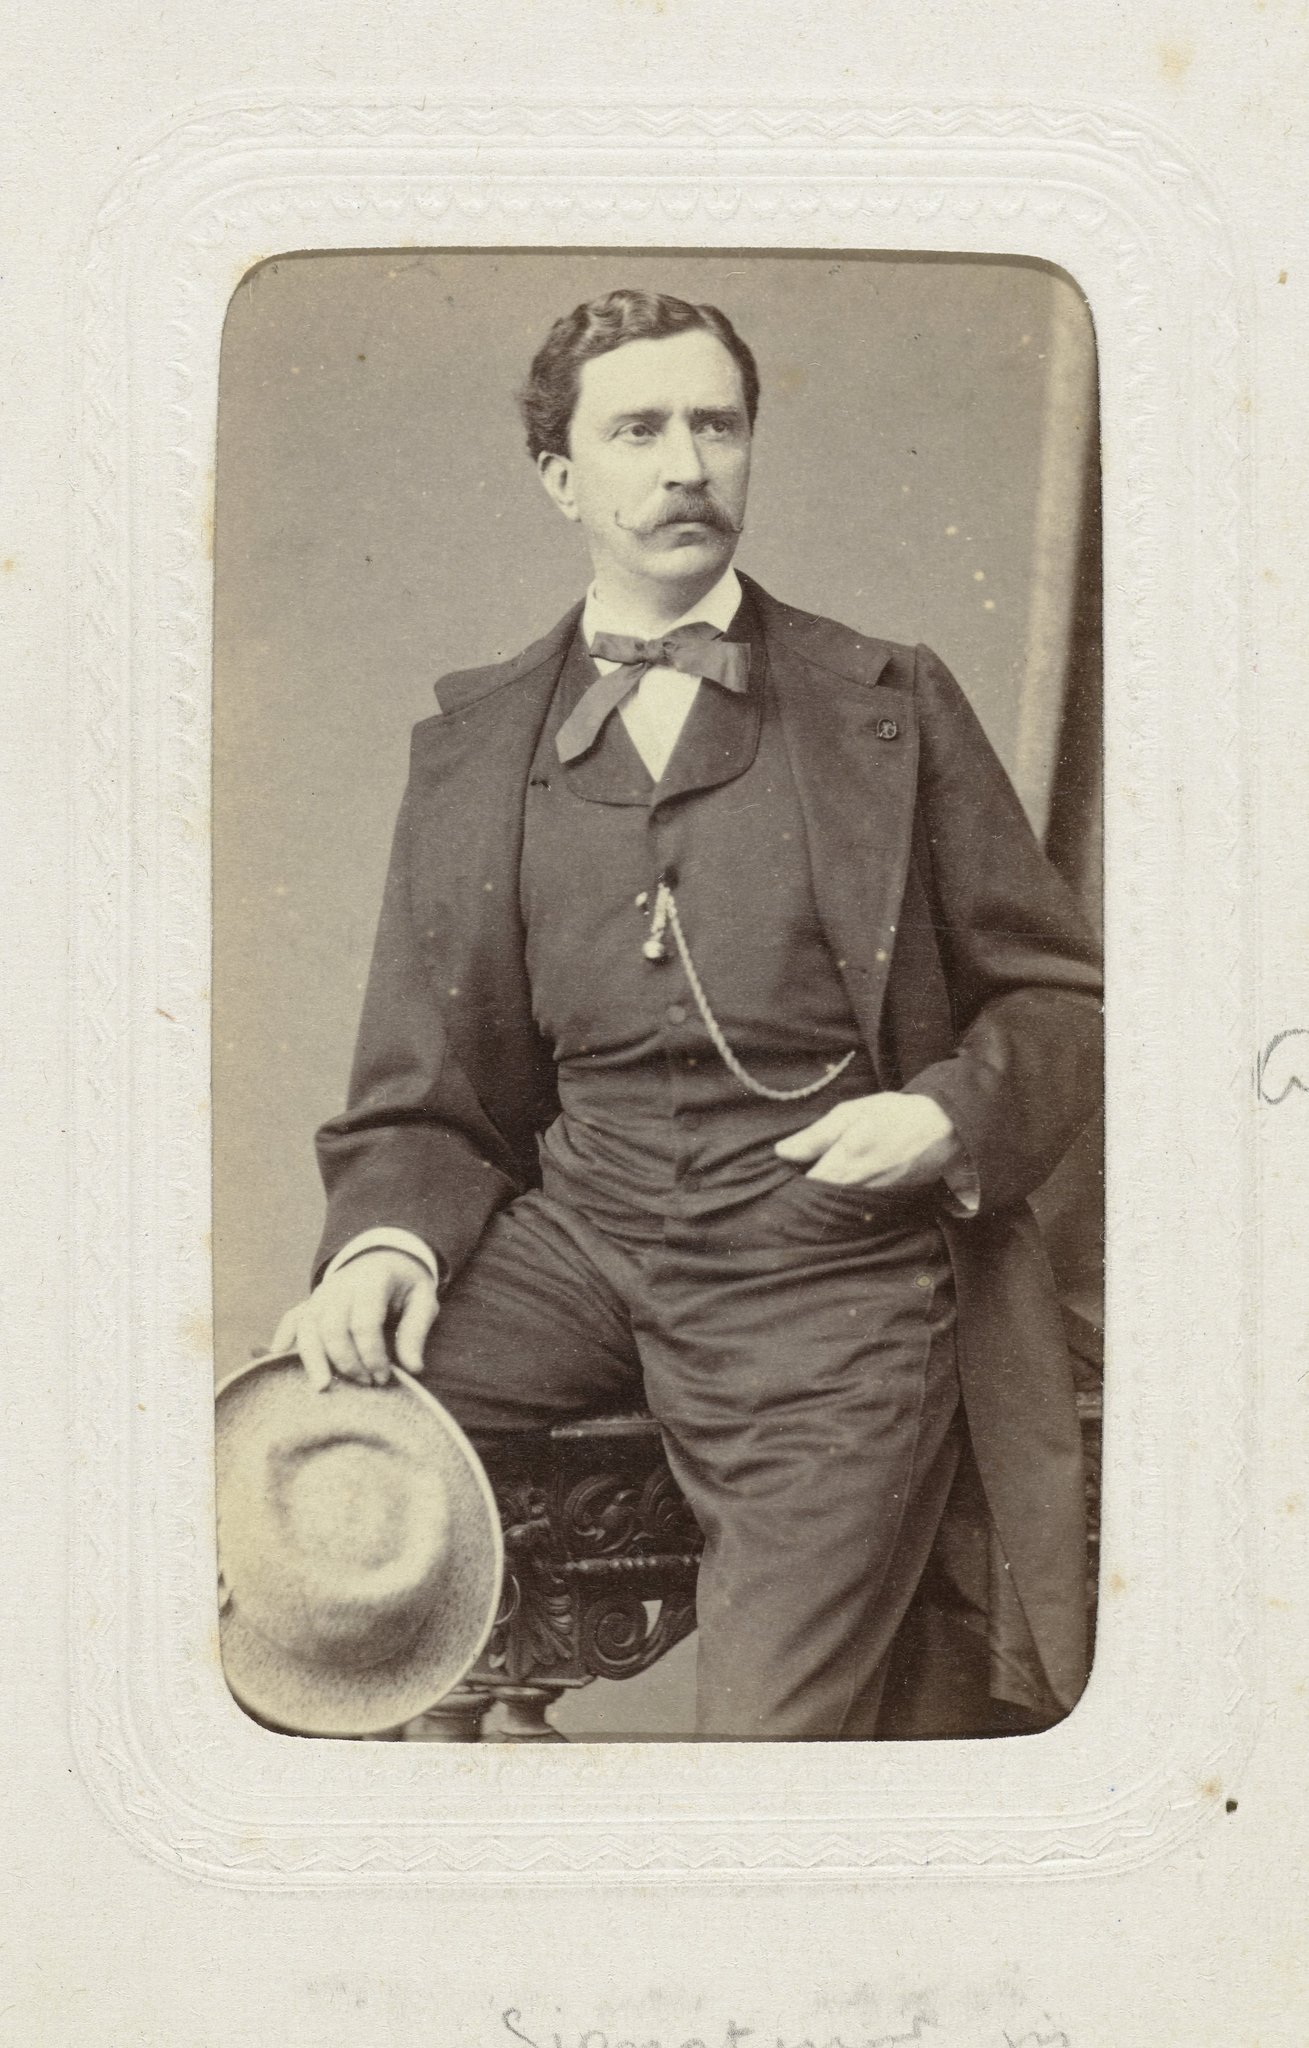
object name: carte de visite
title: Studioportret van een man met snor en hoed in zijn hand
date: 1863-1866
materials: cardboard, paper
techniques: albumen print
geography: istanbul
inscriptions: name: ‘Vernoni’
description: De afgebeelde man is mogelijk de heer Vernoni.